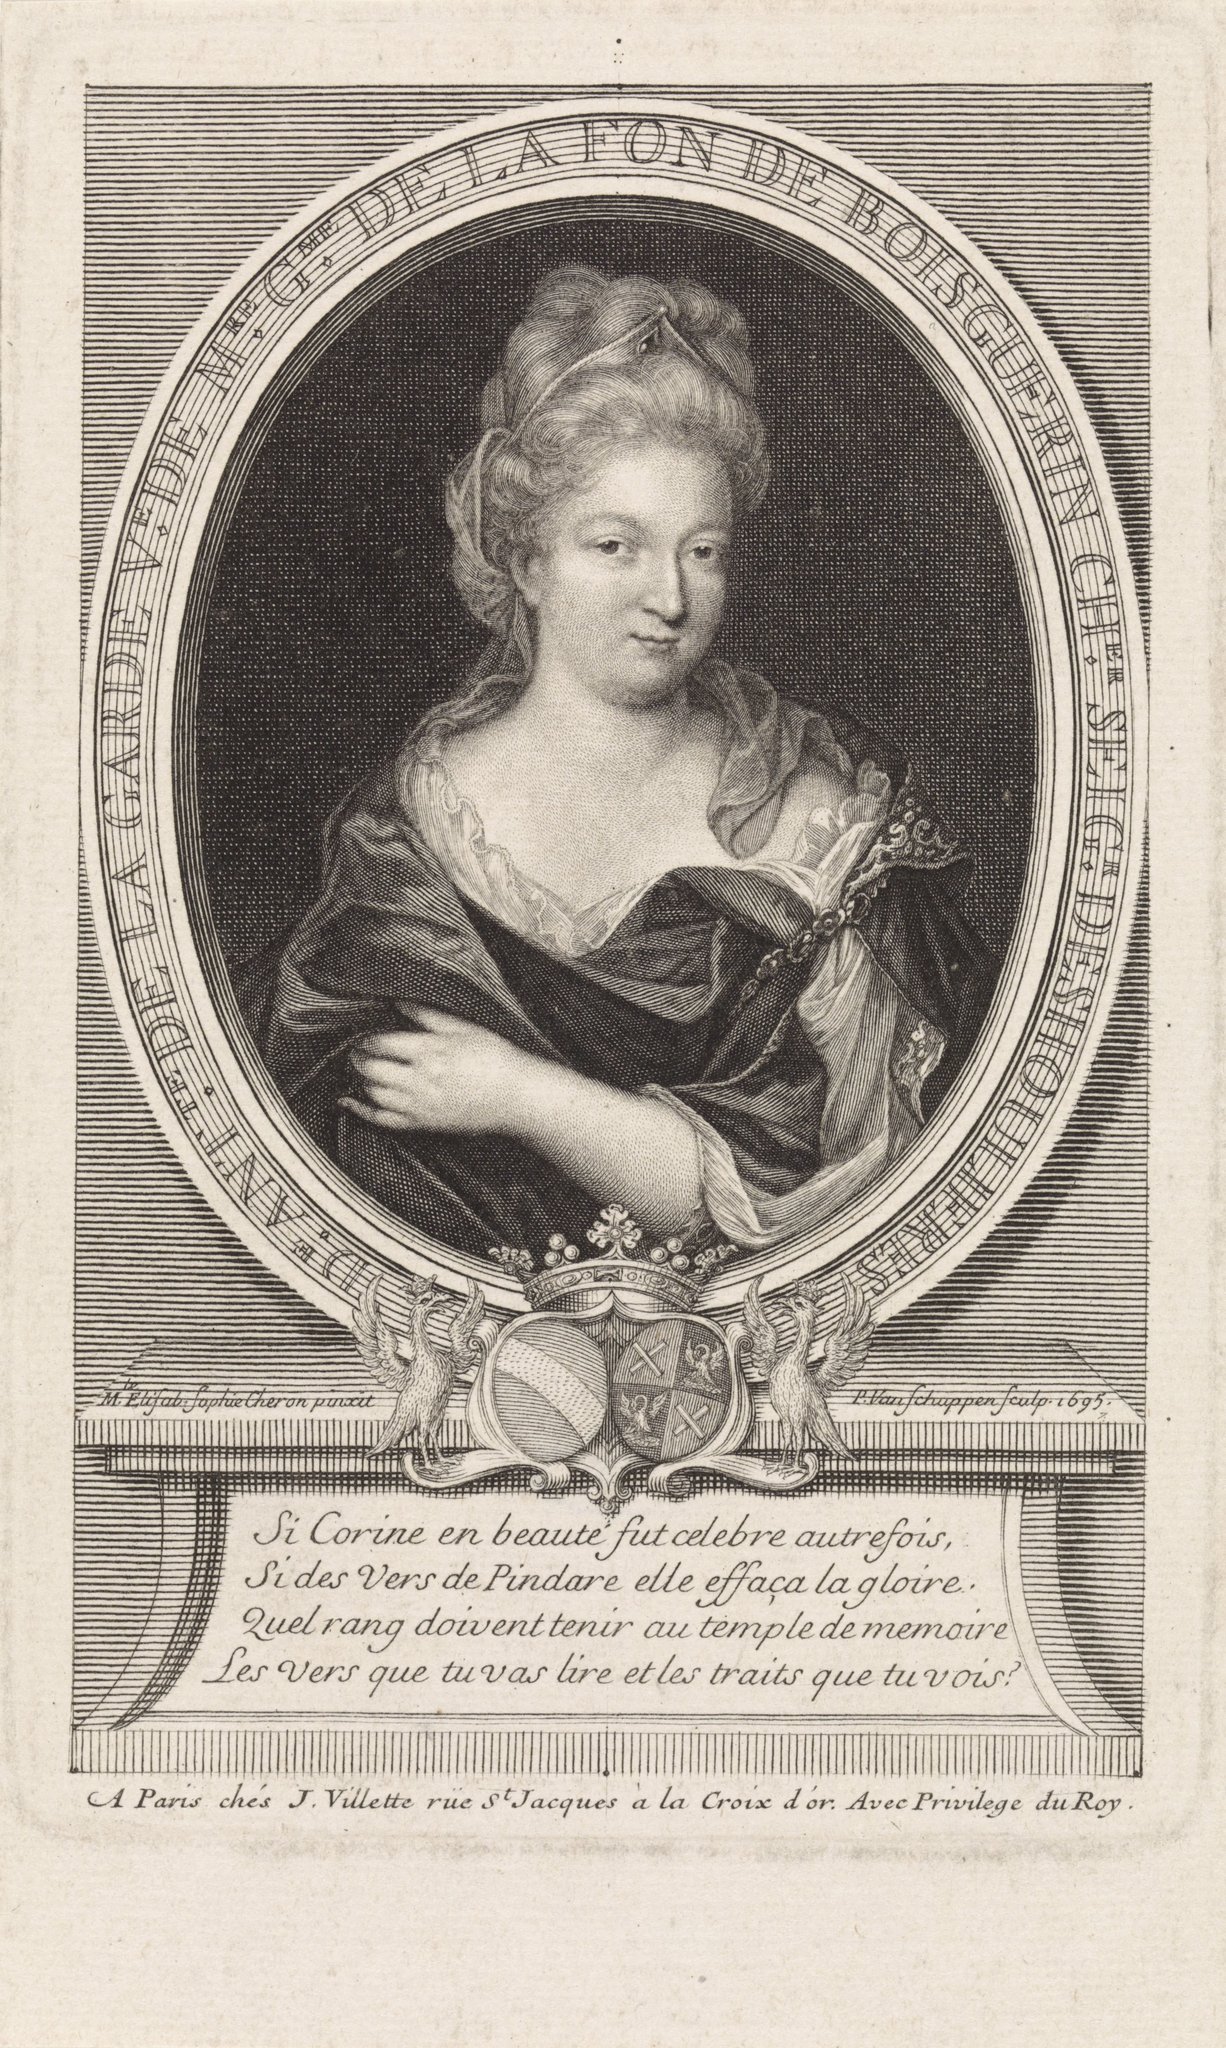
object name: print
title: Portret van Antoinette des Houlières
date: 1607-1695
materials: paper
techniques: engraving, etching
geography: paris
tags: diadem, tiara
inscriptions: collector's mark: Lugt 2228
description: Portret van de schrijfster Antoinette des Houlières. Zij draagt een diadeem in het haar. Onder het portret twee wapenschilden, rondom haar naam. Op het piëdestal een lofdicht in het Frans op haar literaire prestaties en haar uiterlijk.